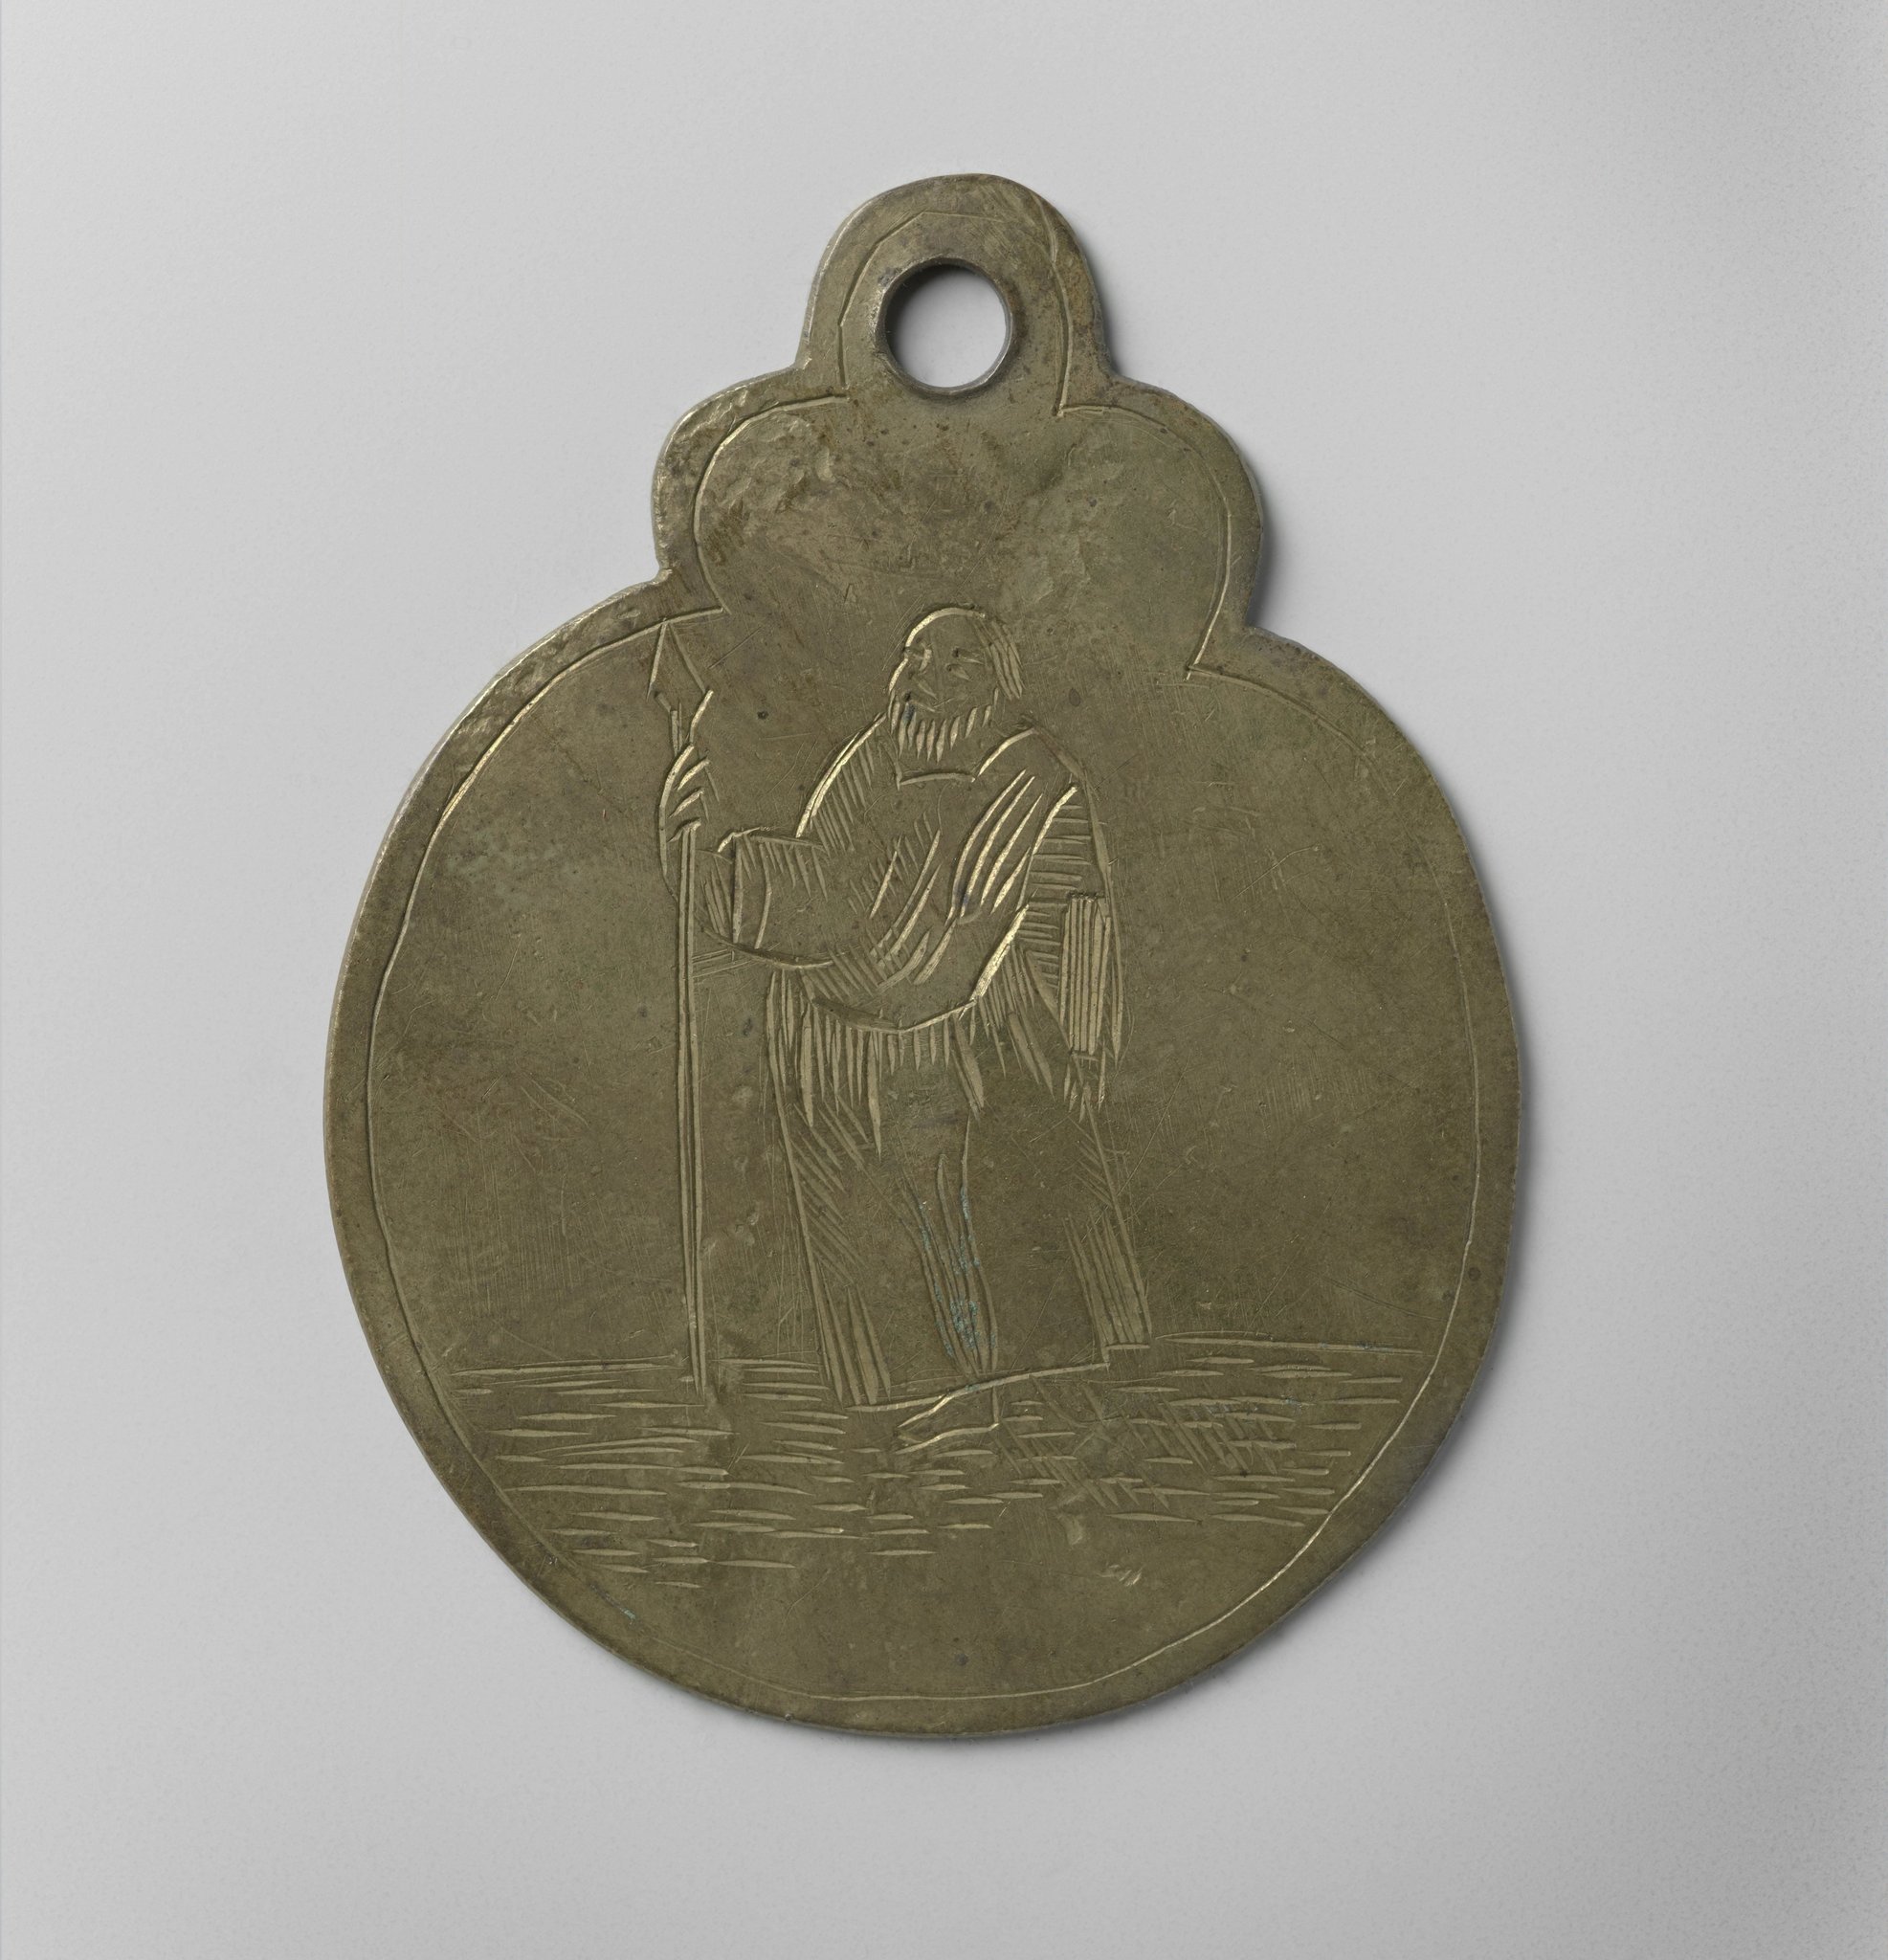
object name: medal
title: Speldenmakersgilde van 's-Hertogenbosch, gildepenning met no. 24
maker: Anonymous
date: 1600-1800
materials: brass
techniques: engraving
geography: den bosch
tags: den bosch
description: Messing penning aan draagoog. Voorzijde: St. Thomas, blootsvoets met lans in rechterhand en boek onder linkerarm. Keerzijde: opschrift; onder draagoog: cijfer No. 24